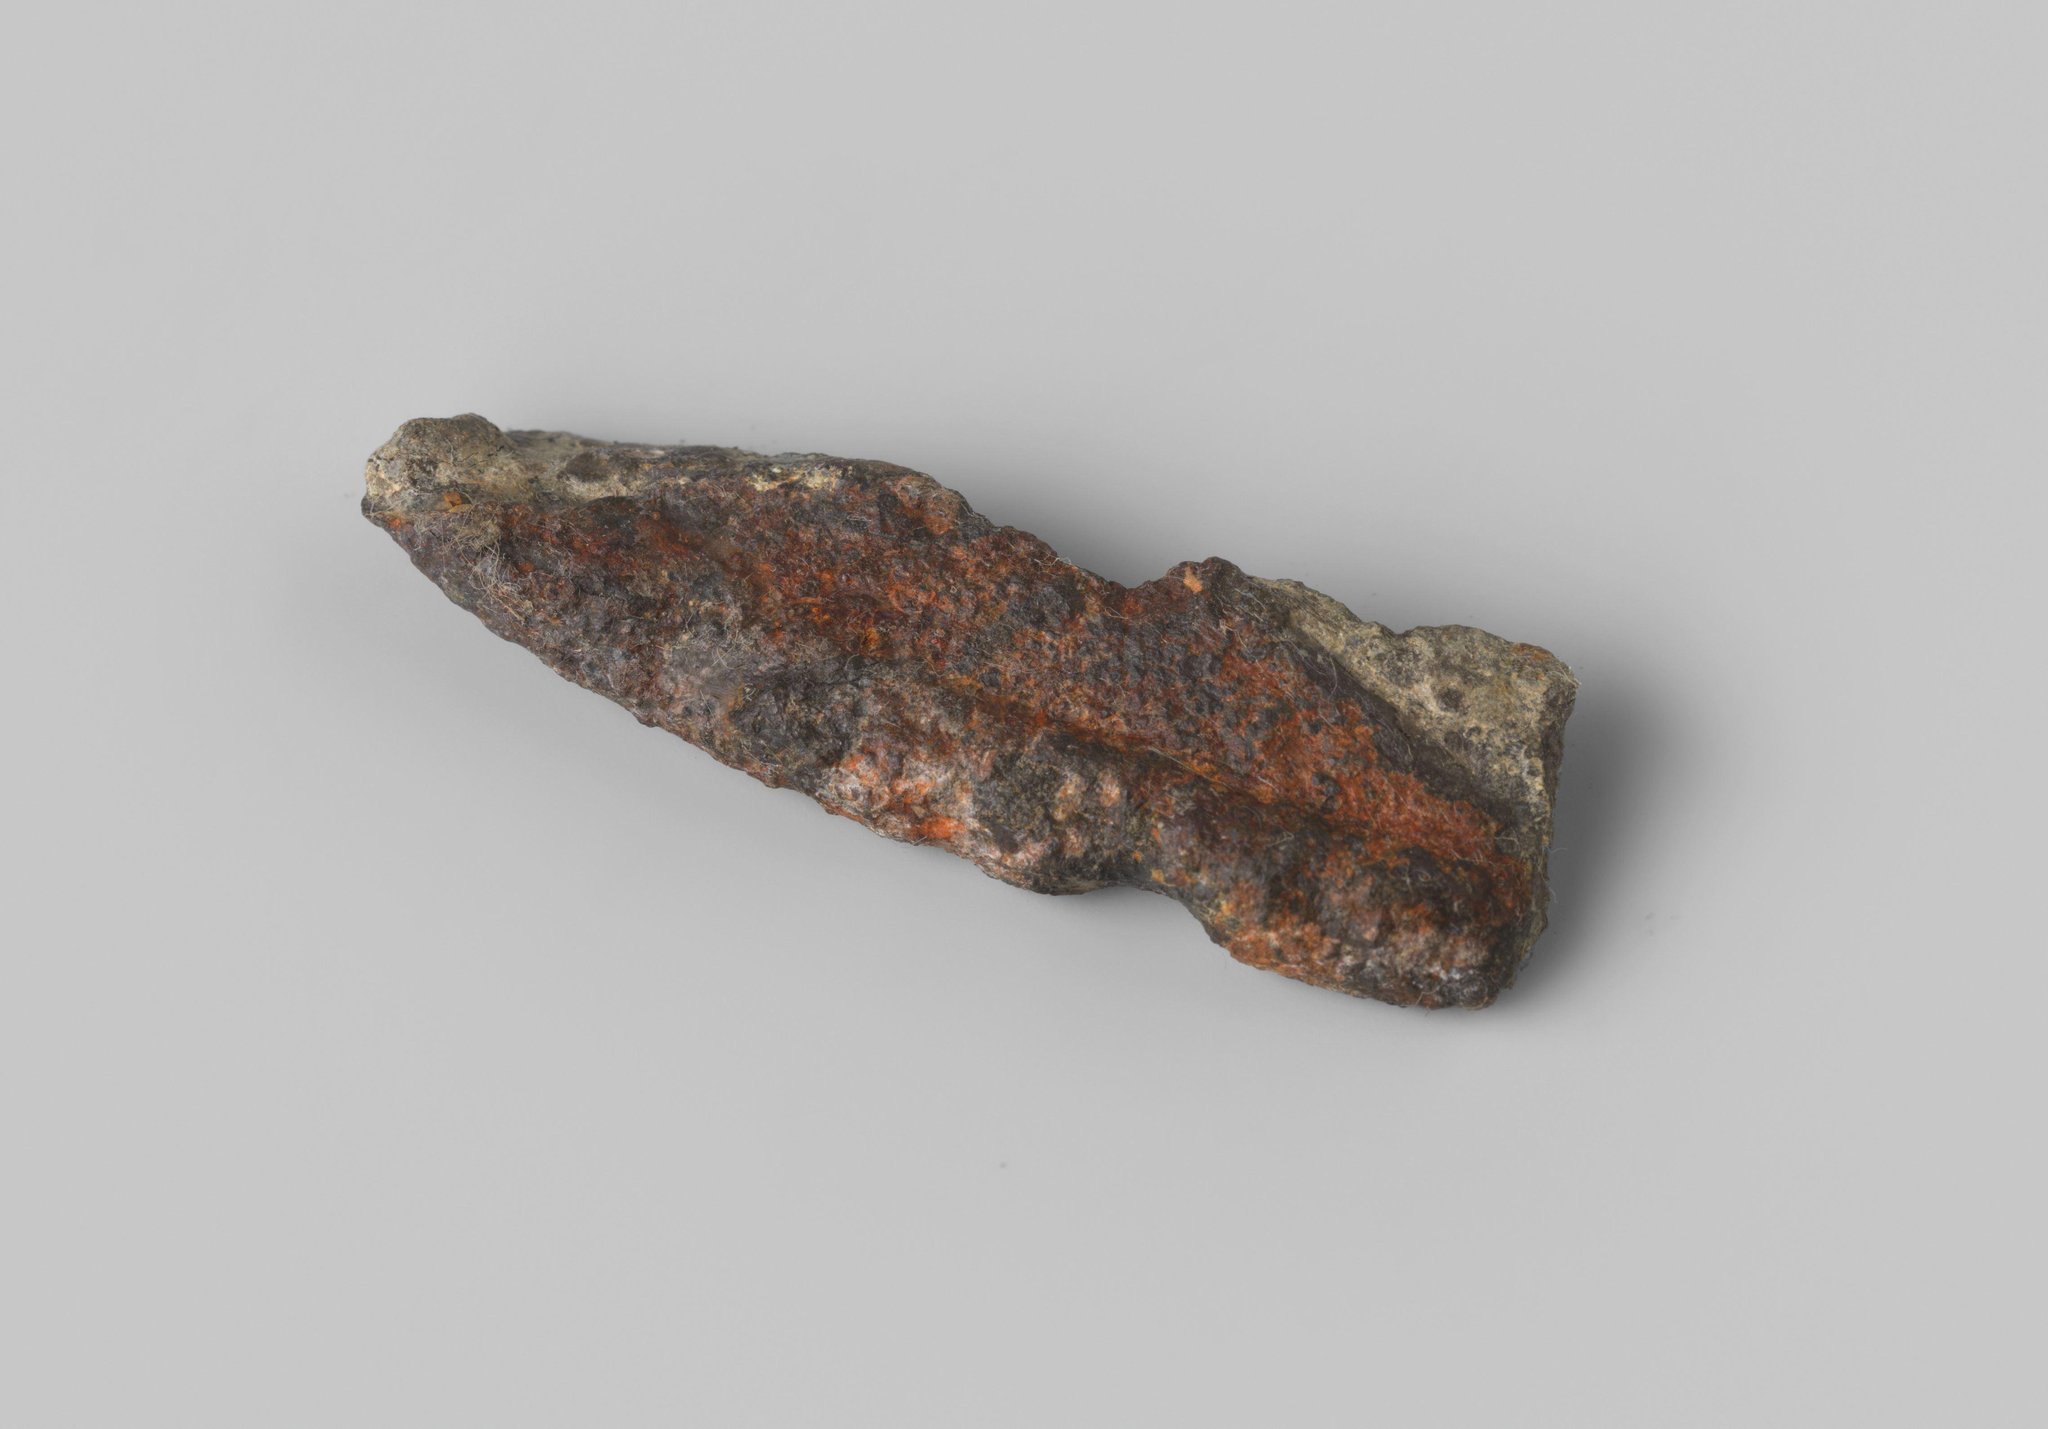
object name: plate dish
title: Fragment bord uit het wrak van de Oost-Indiëvaarder Hollandia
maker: Anonymous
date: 1700-1743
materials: tin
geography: netherlands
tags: verenigde oostindische compagnie, hollandia (schip), annet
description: Plate, fragm of rim, id. NG 1980-27H2288, corroded.